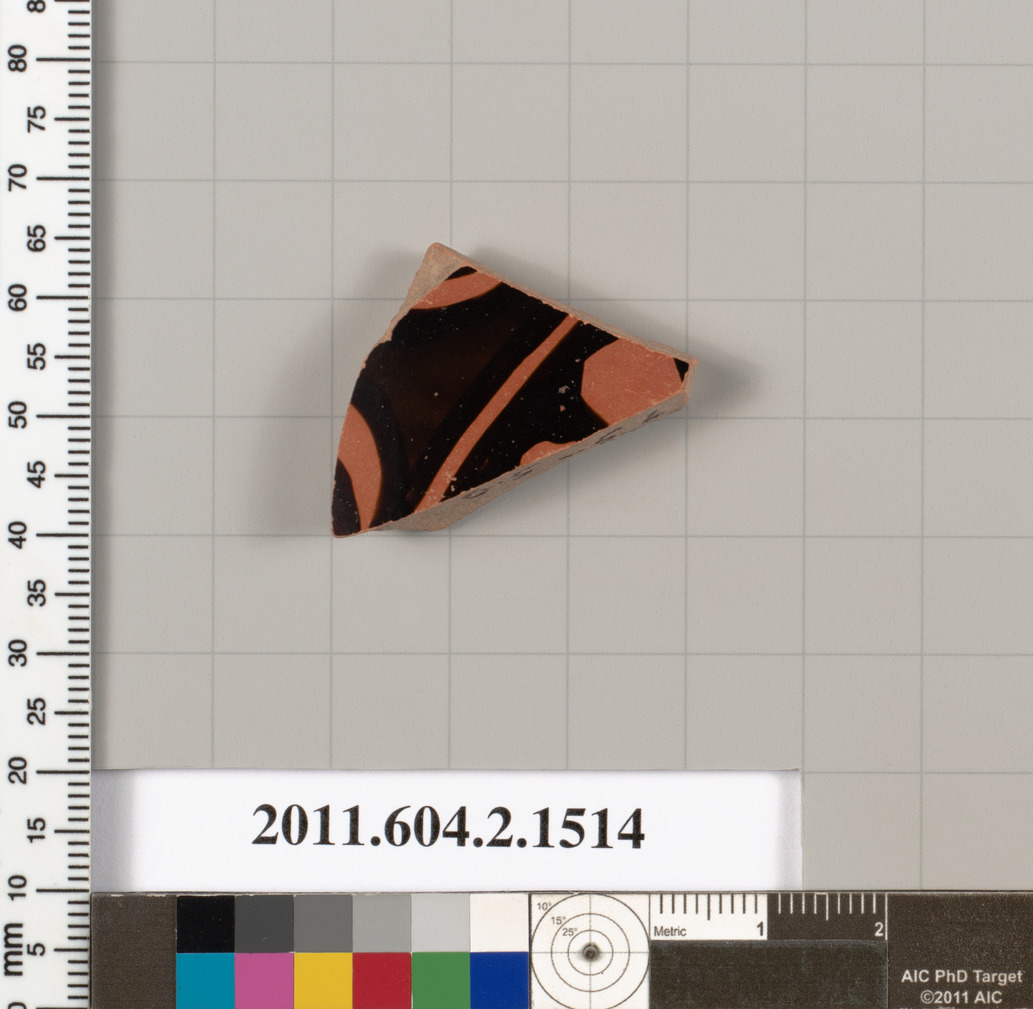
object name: skyphos fragment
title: Terracotta fragment of a skyphos (deep drinking cup)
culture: greek, attic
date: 460-440 BCE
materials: terracotta